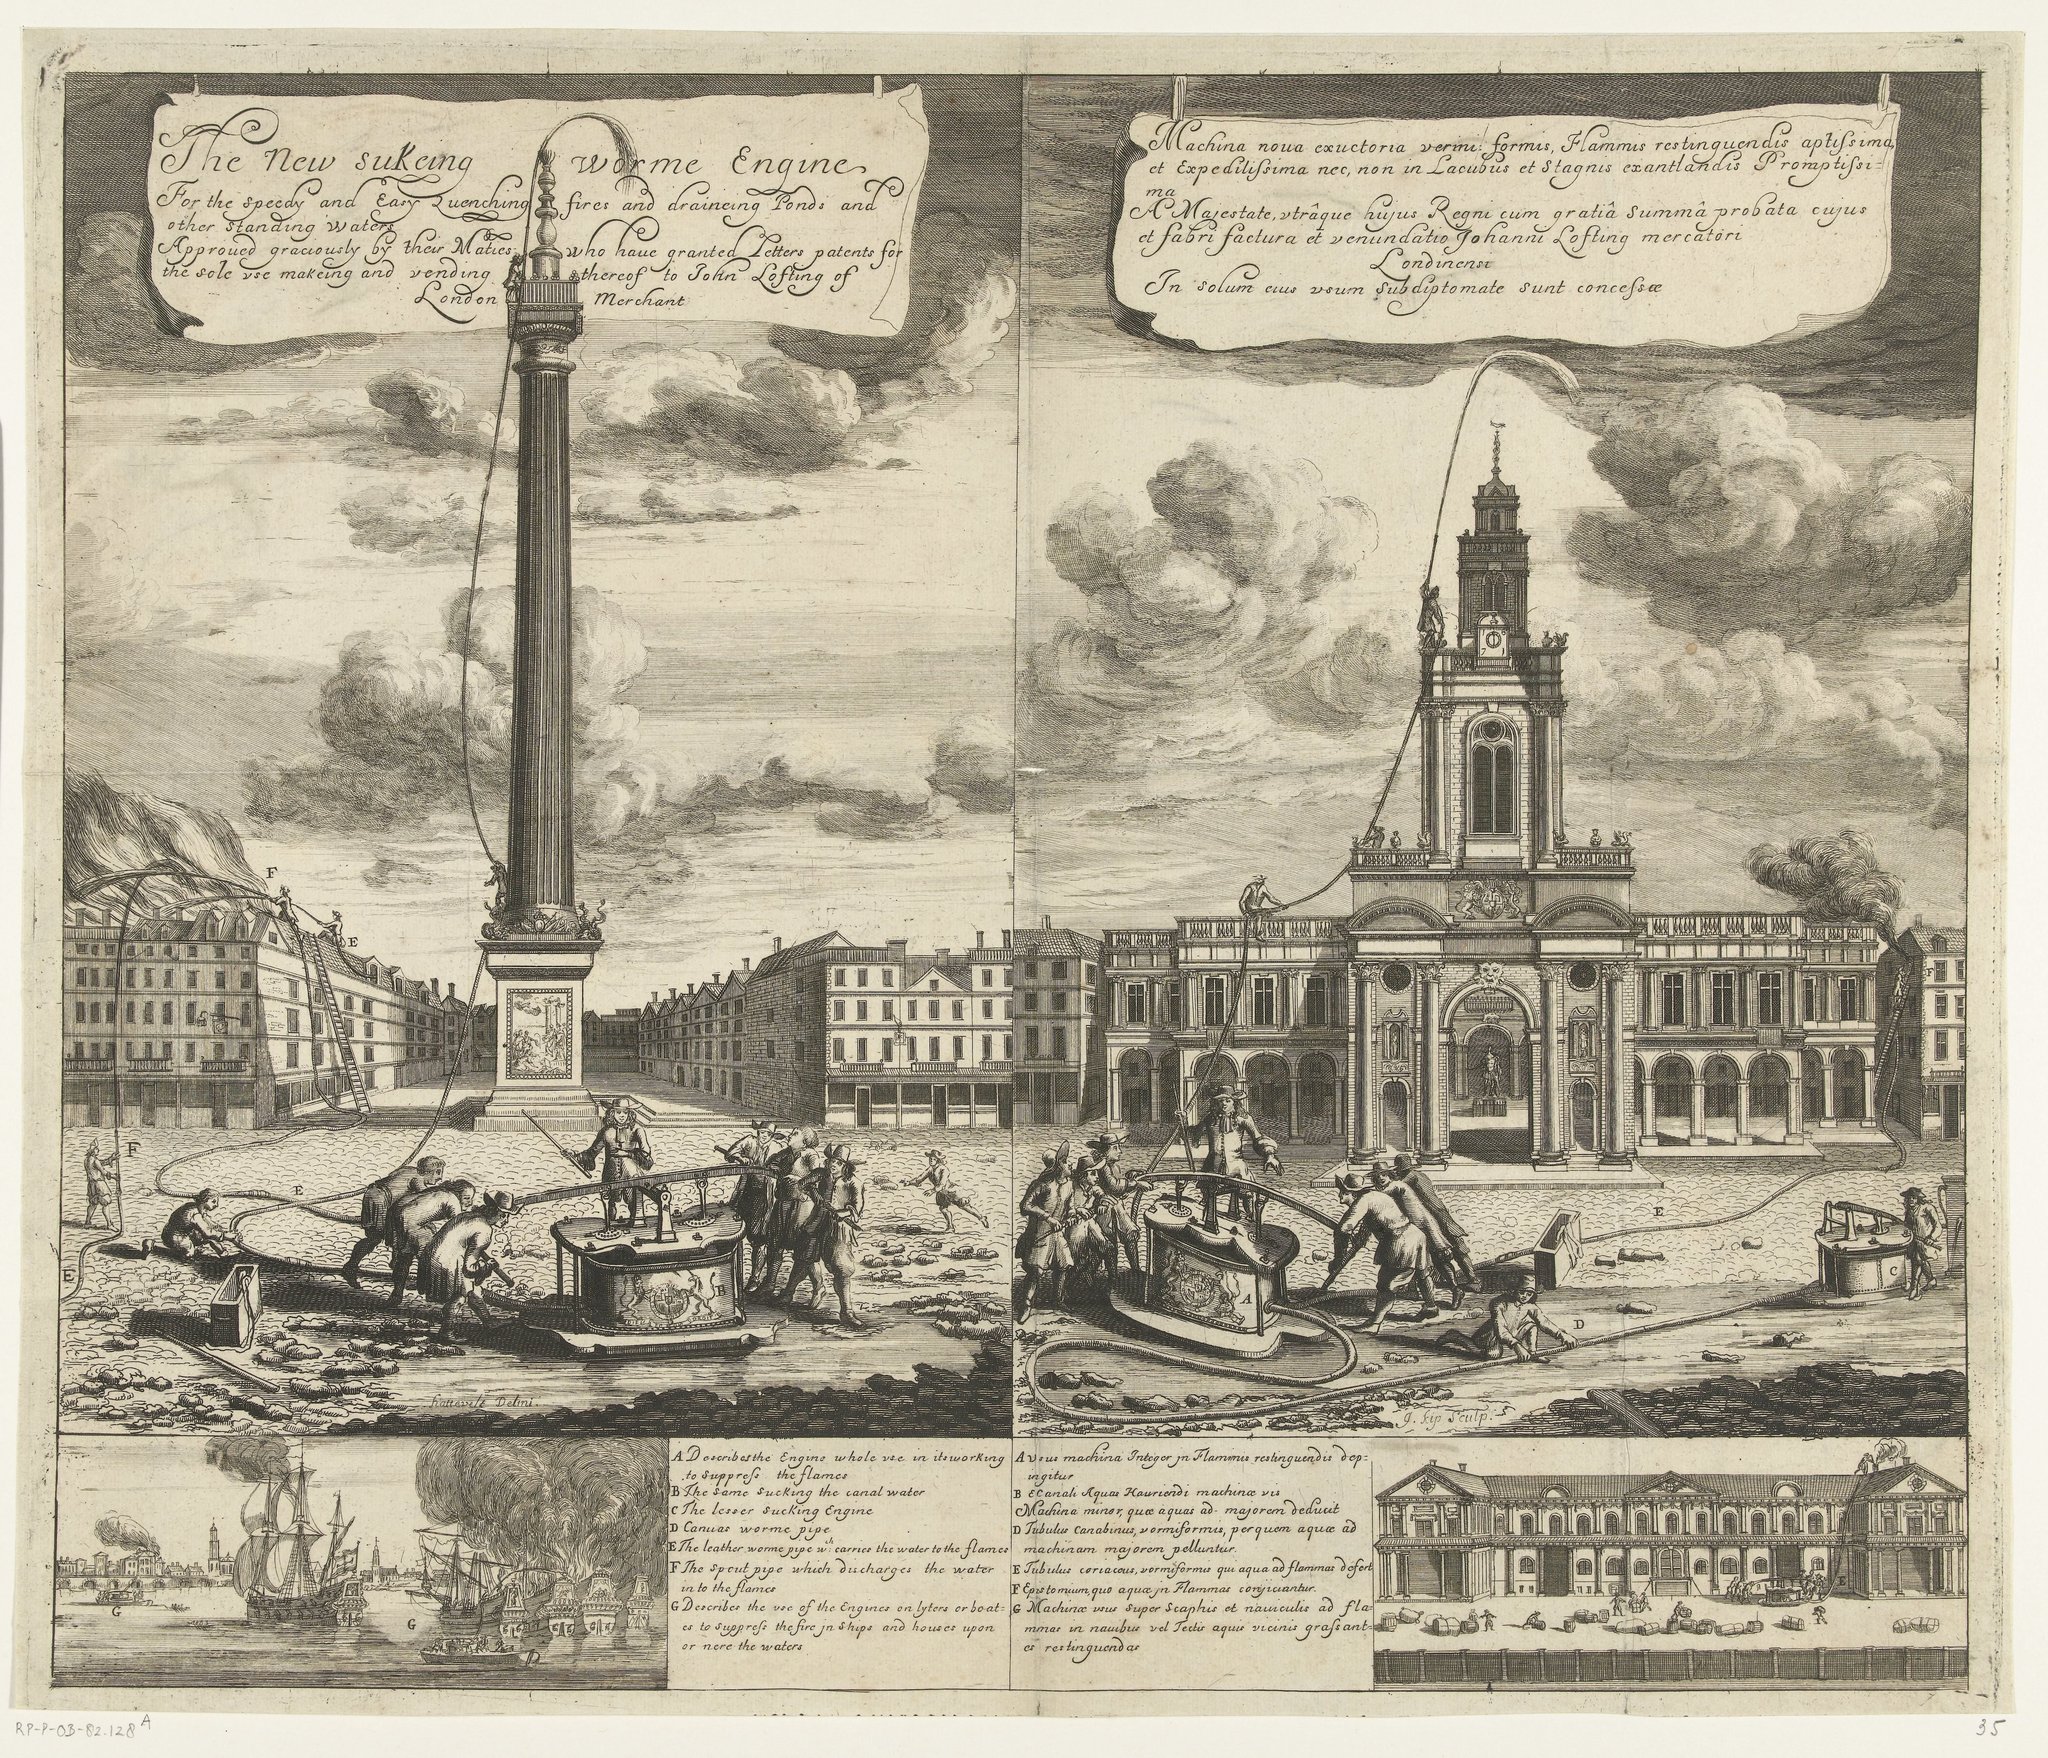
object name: print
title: The new sukeing worme Engine For the speedy and easy quenching fires and draineing Ponds and other standing waters (...)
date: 1690-1700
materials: paper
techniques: etching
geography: london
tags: amsterdam, painter, print maker, draughtsman, jan van der heyden, fire-extinguishing equipment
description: Voorstelling van het gebruik van een nieuw type slangbrandspuit uitgevonden door de Engelsman John Lofting, tegen de achtergrond van gebouwen in Londen, ca. 1690-1700. Links bij het monument ter nagedachtenis aan de grote brand van 1666: Monument to the Great Fire of London, rechts een tweede voorstelling met een demonstratie voor de Royal Exchange (Beurs). Bovenaan twee banderollen met de titels in het Engels en Latijn. Hierin wordt vermeld dat de machines verkrijgbaar zijn bij de octrooihouder John Lofting te Londen. Onderaan twee kleine scènes van de toepassing van de slangbrandspuiten bij brand op schepen en bij een pakhuis. Hierbij de legenda's A-G in het Engels en Latijn. Bij de prent behoort een tekstblad. Behoort tot de bijprenten bij het Brandspuitenboek van Jan van der Heyden.